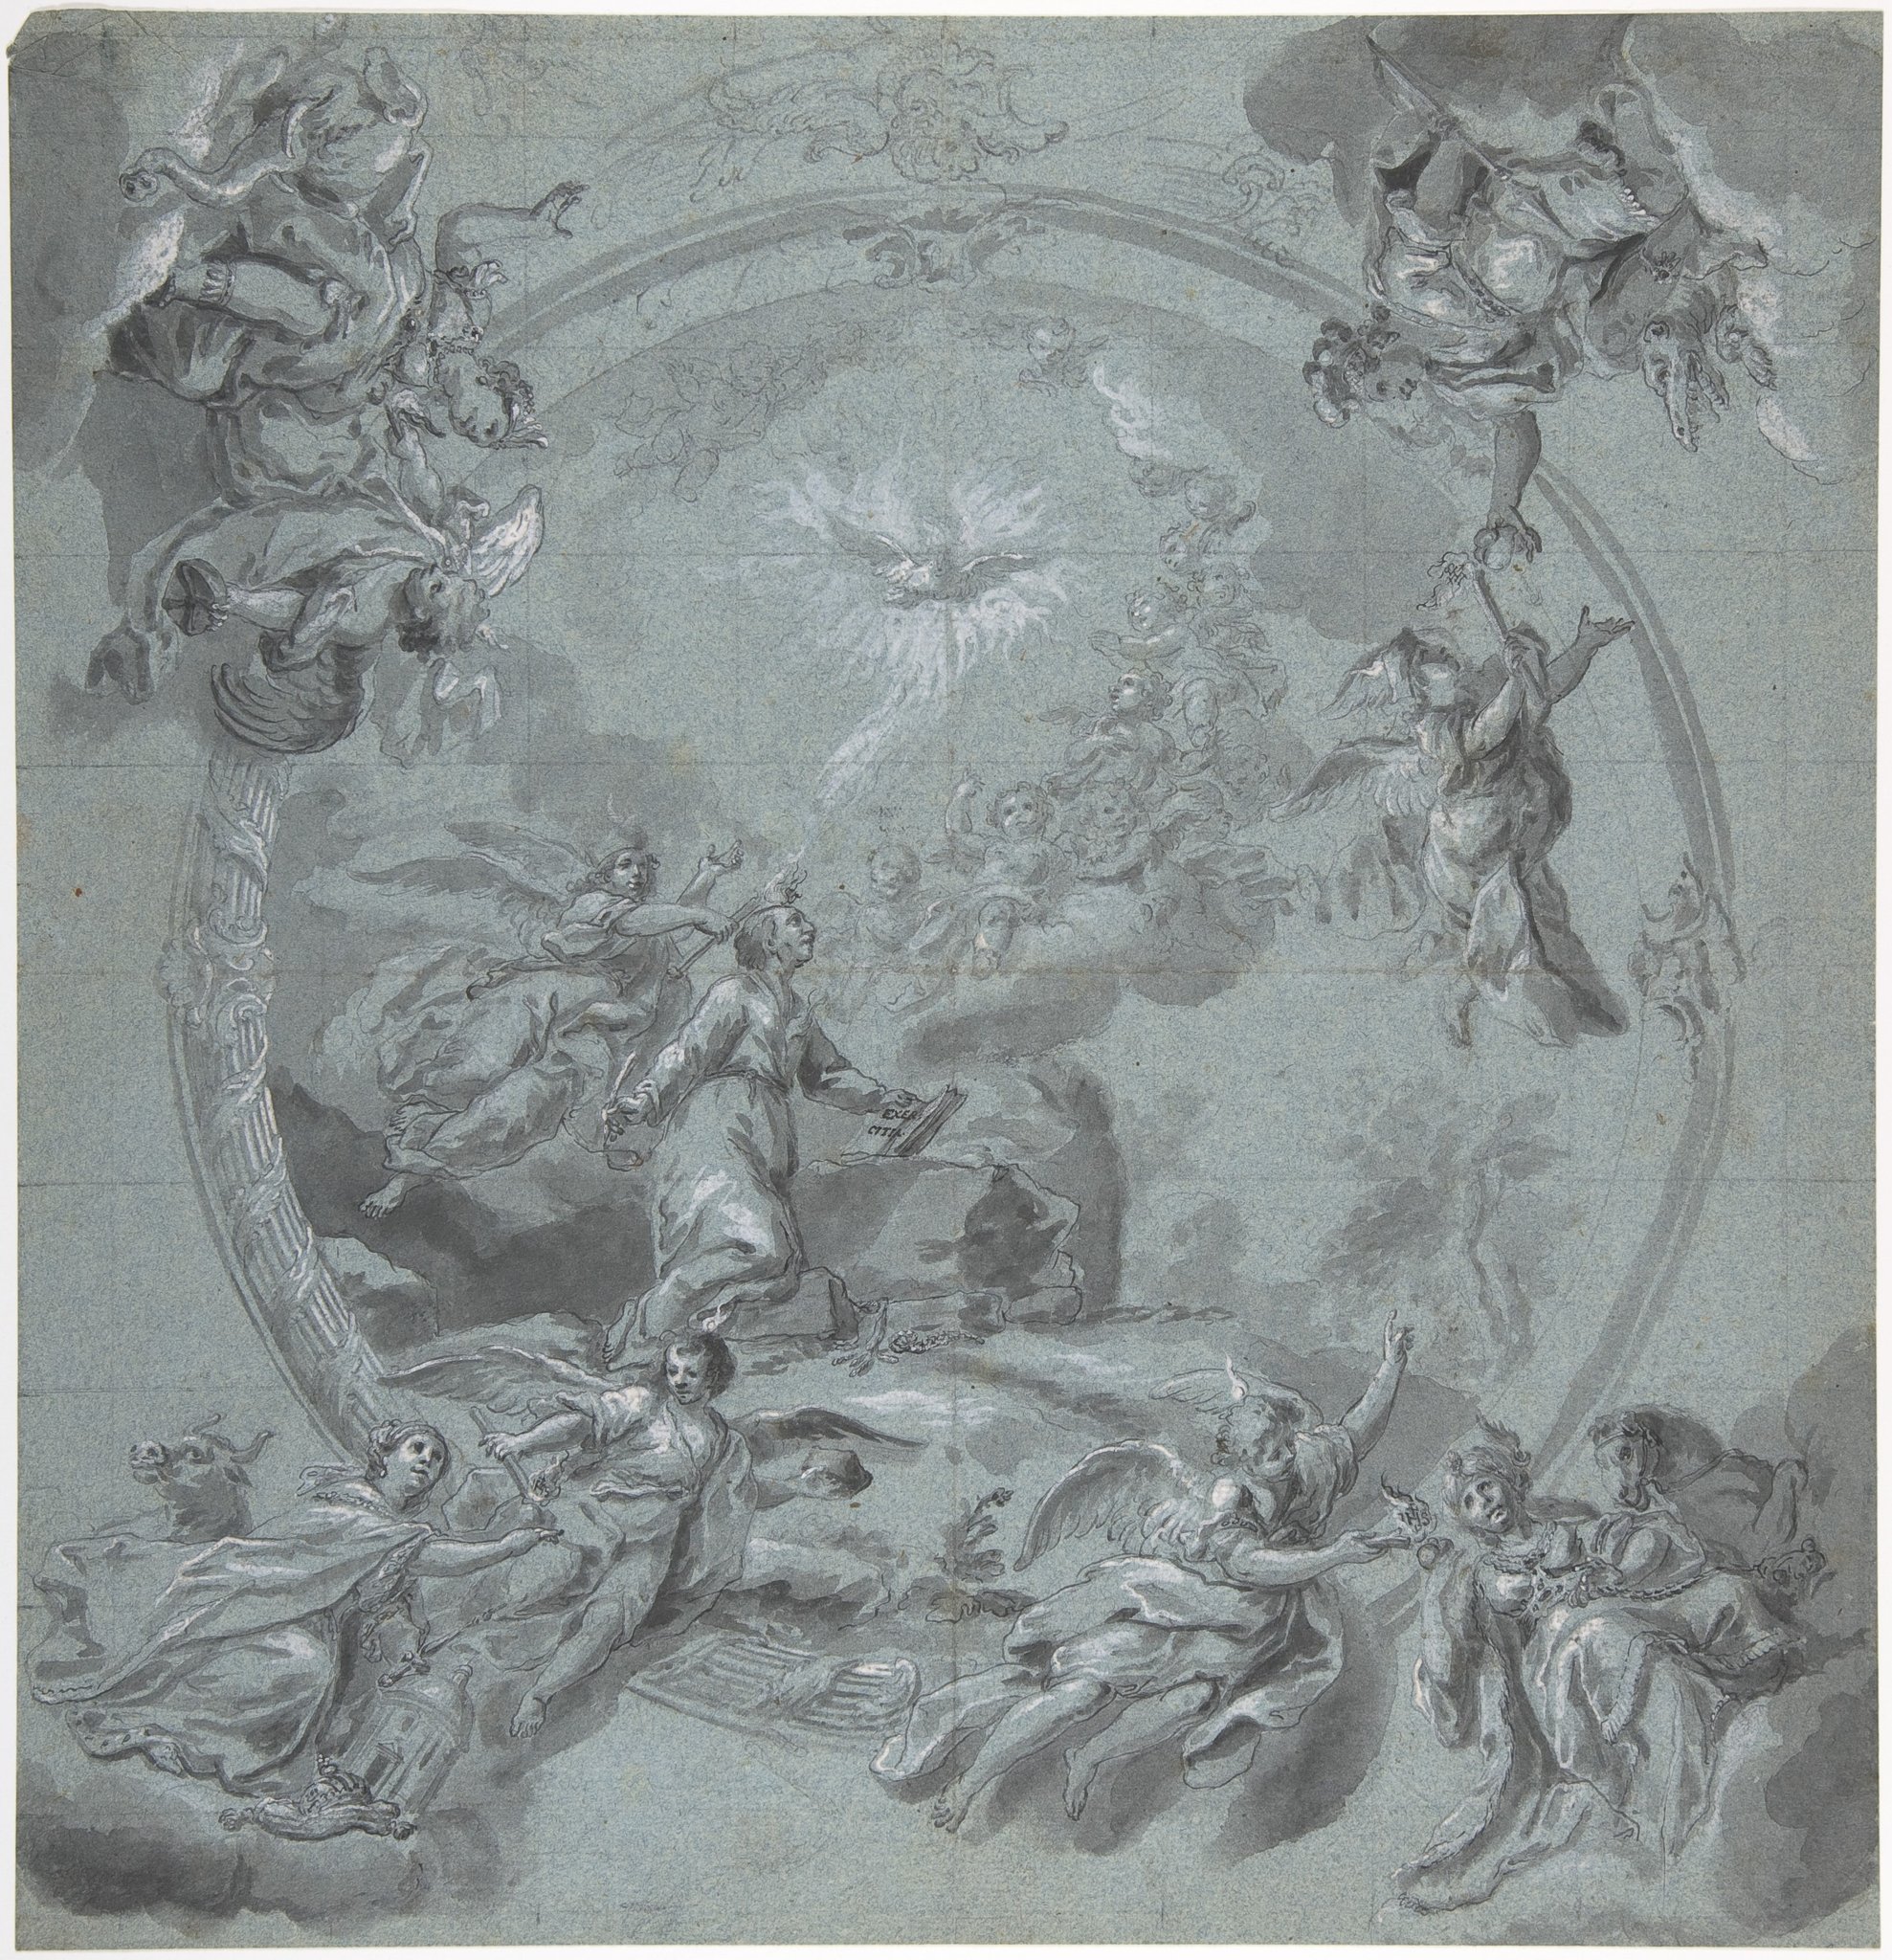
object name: drawing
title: Saint Ignatius of Loyola and Allegories of the Four Continents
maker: felix anton scheffler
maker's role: artist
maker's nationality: german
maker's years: 1701-1760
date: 1715-1760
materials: chalk, ink, paper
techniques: heightening, pen, wash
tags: cows,horses,angels